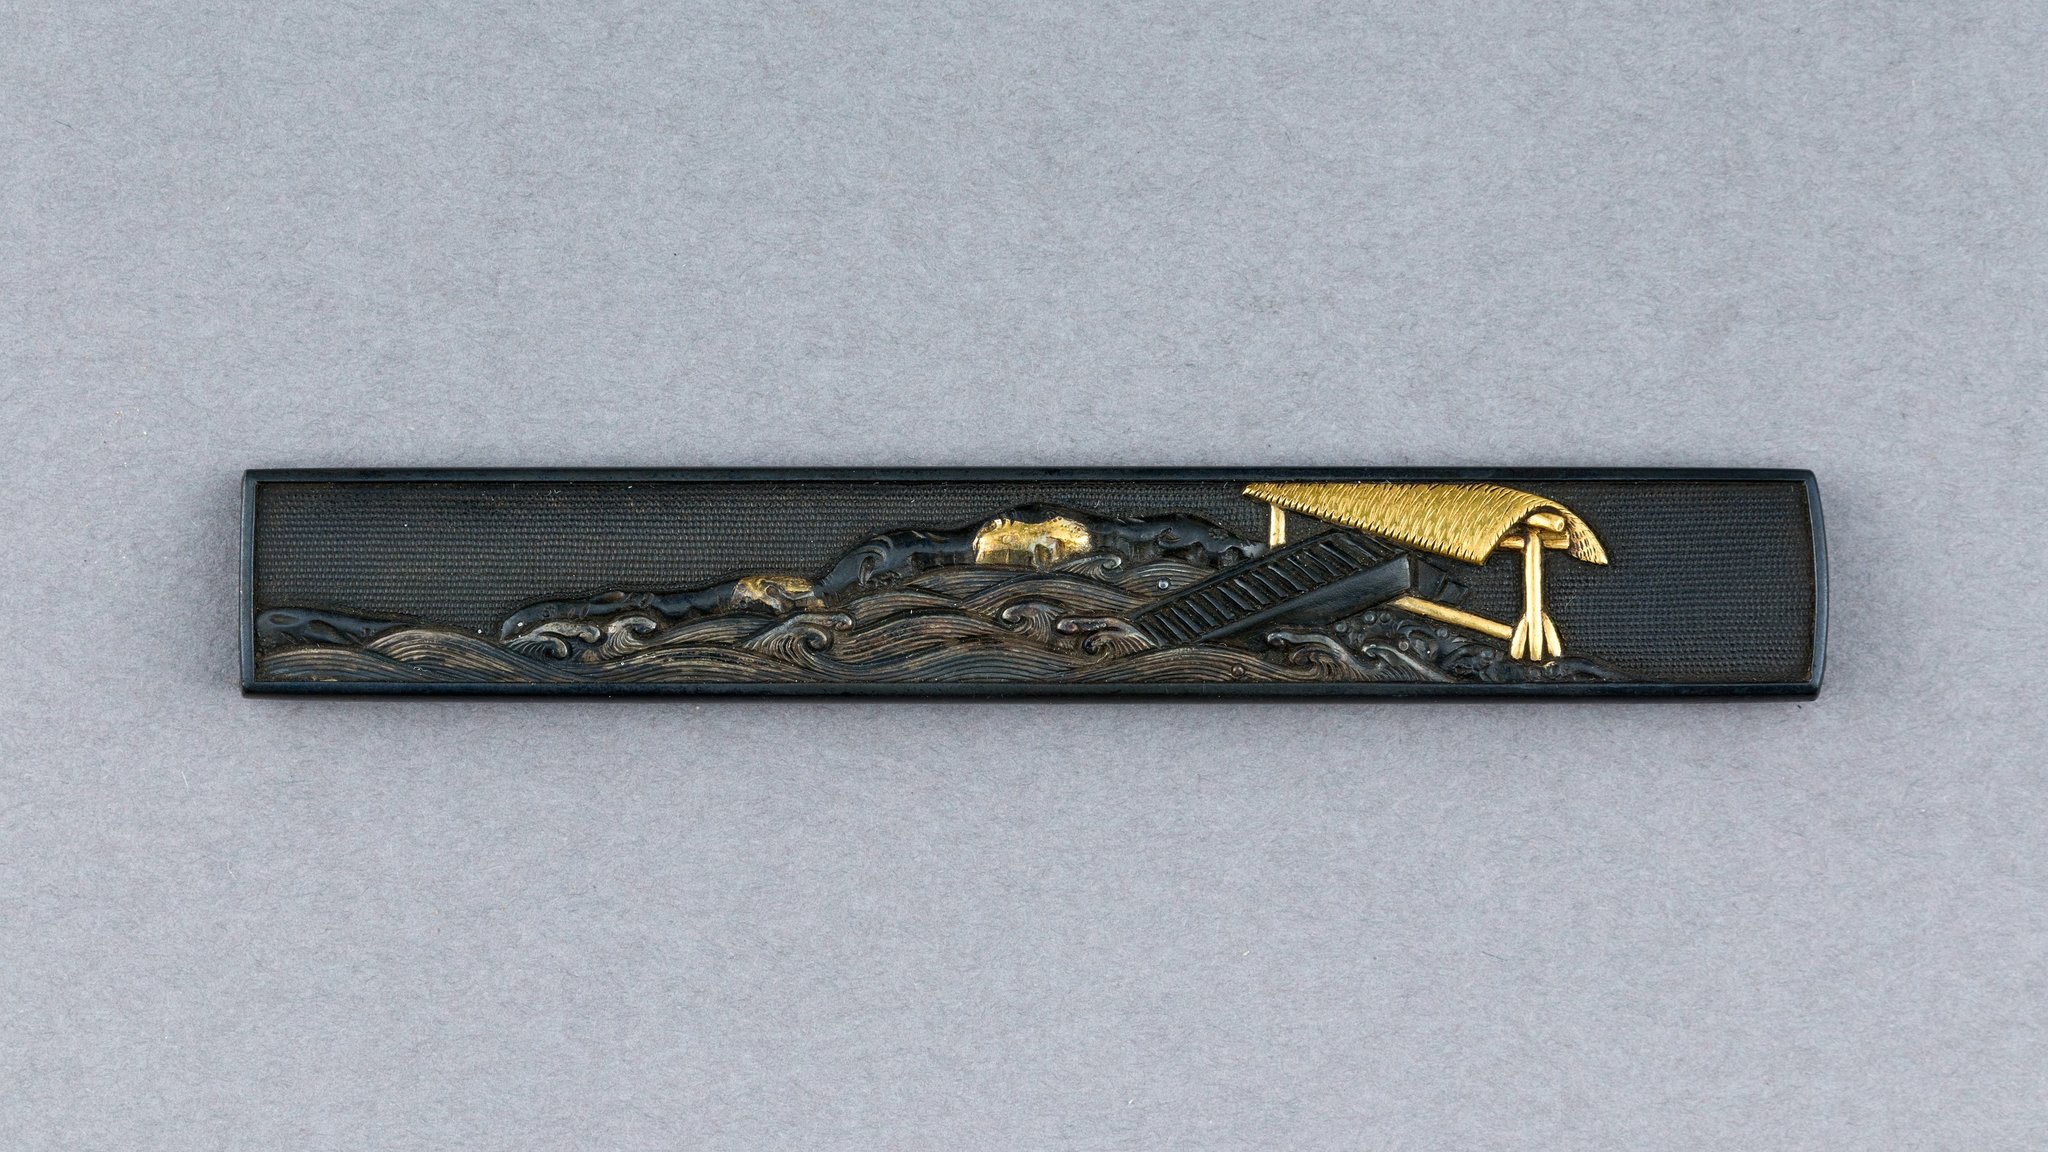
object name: knife handle kozuka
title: Knife Handle (Kozuka)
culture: japanese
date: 1615-1868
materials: gold alloy, gold, silver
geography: japan